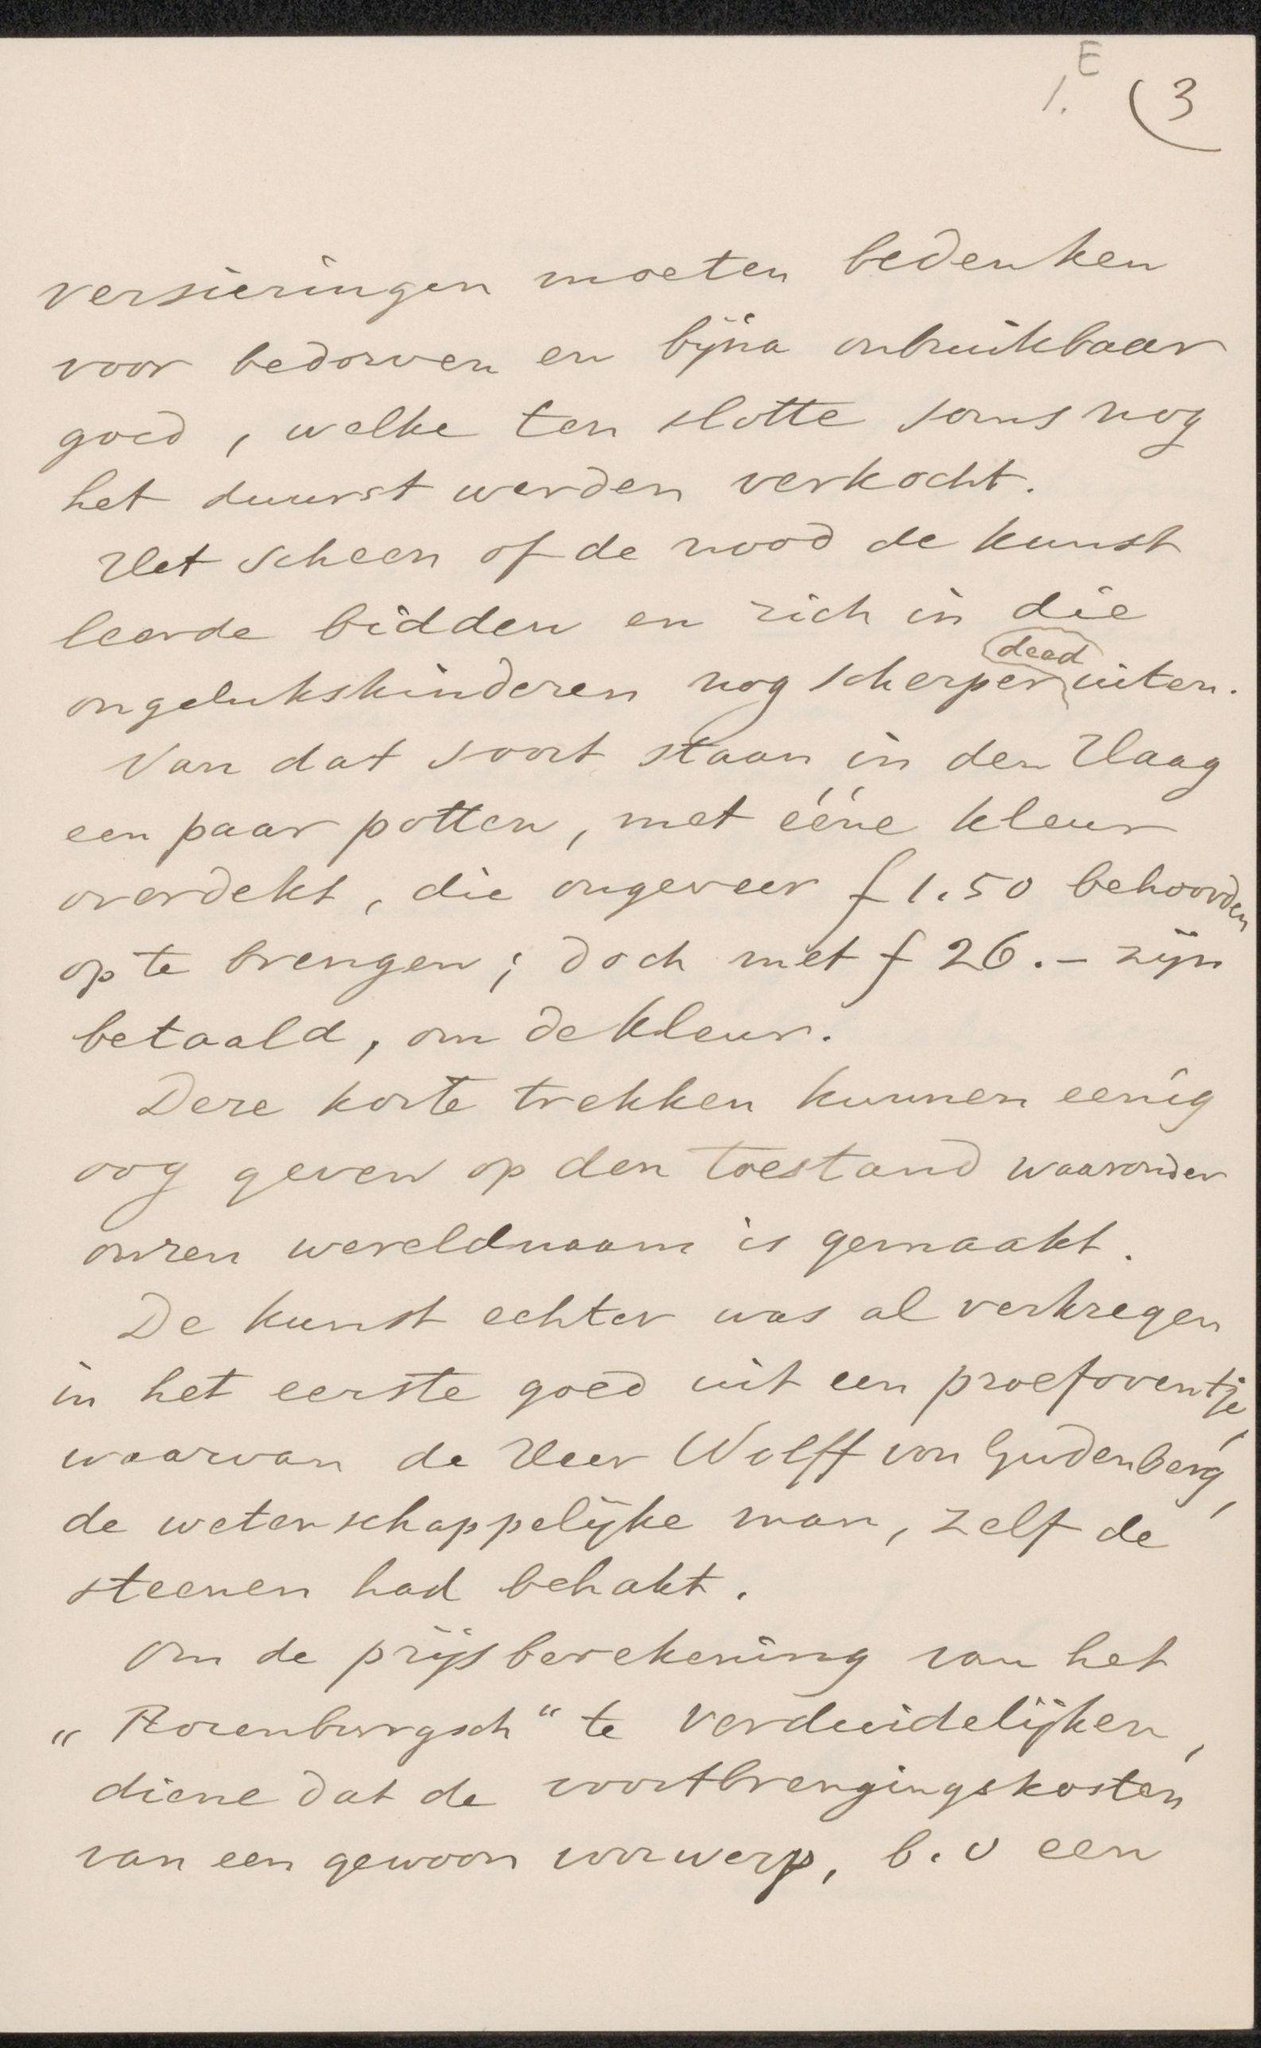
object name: letter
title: Brief aan Pieter Haverkorn van Rijsewijk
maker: theo colenbrander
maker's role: draughtsman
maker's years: 1841-1930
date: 1851-1915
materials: ink, paper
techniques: pen, writing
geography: arnhem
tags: pieter haverkorn van rijsewijk, applied arts, arts and crafts; industrial design, money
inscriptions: collector's mark: ‘RPK’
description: RP-D-COLENBRANDER.T.C.-1A en RP-D-COLENBRANDER-1B tot en met RP-D-COLENBRANDER-1H vormen een doorlopende brief. RP-D-COLENBRANDER-1I is verstuurd als bijlage bij deze brief.